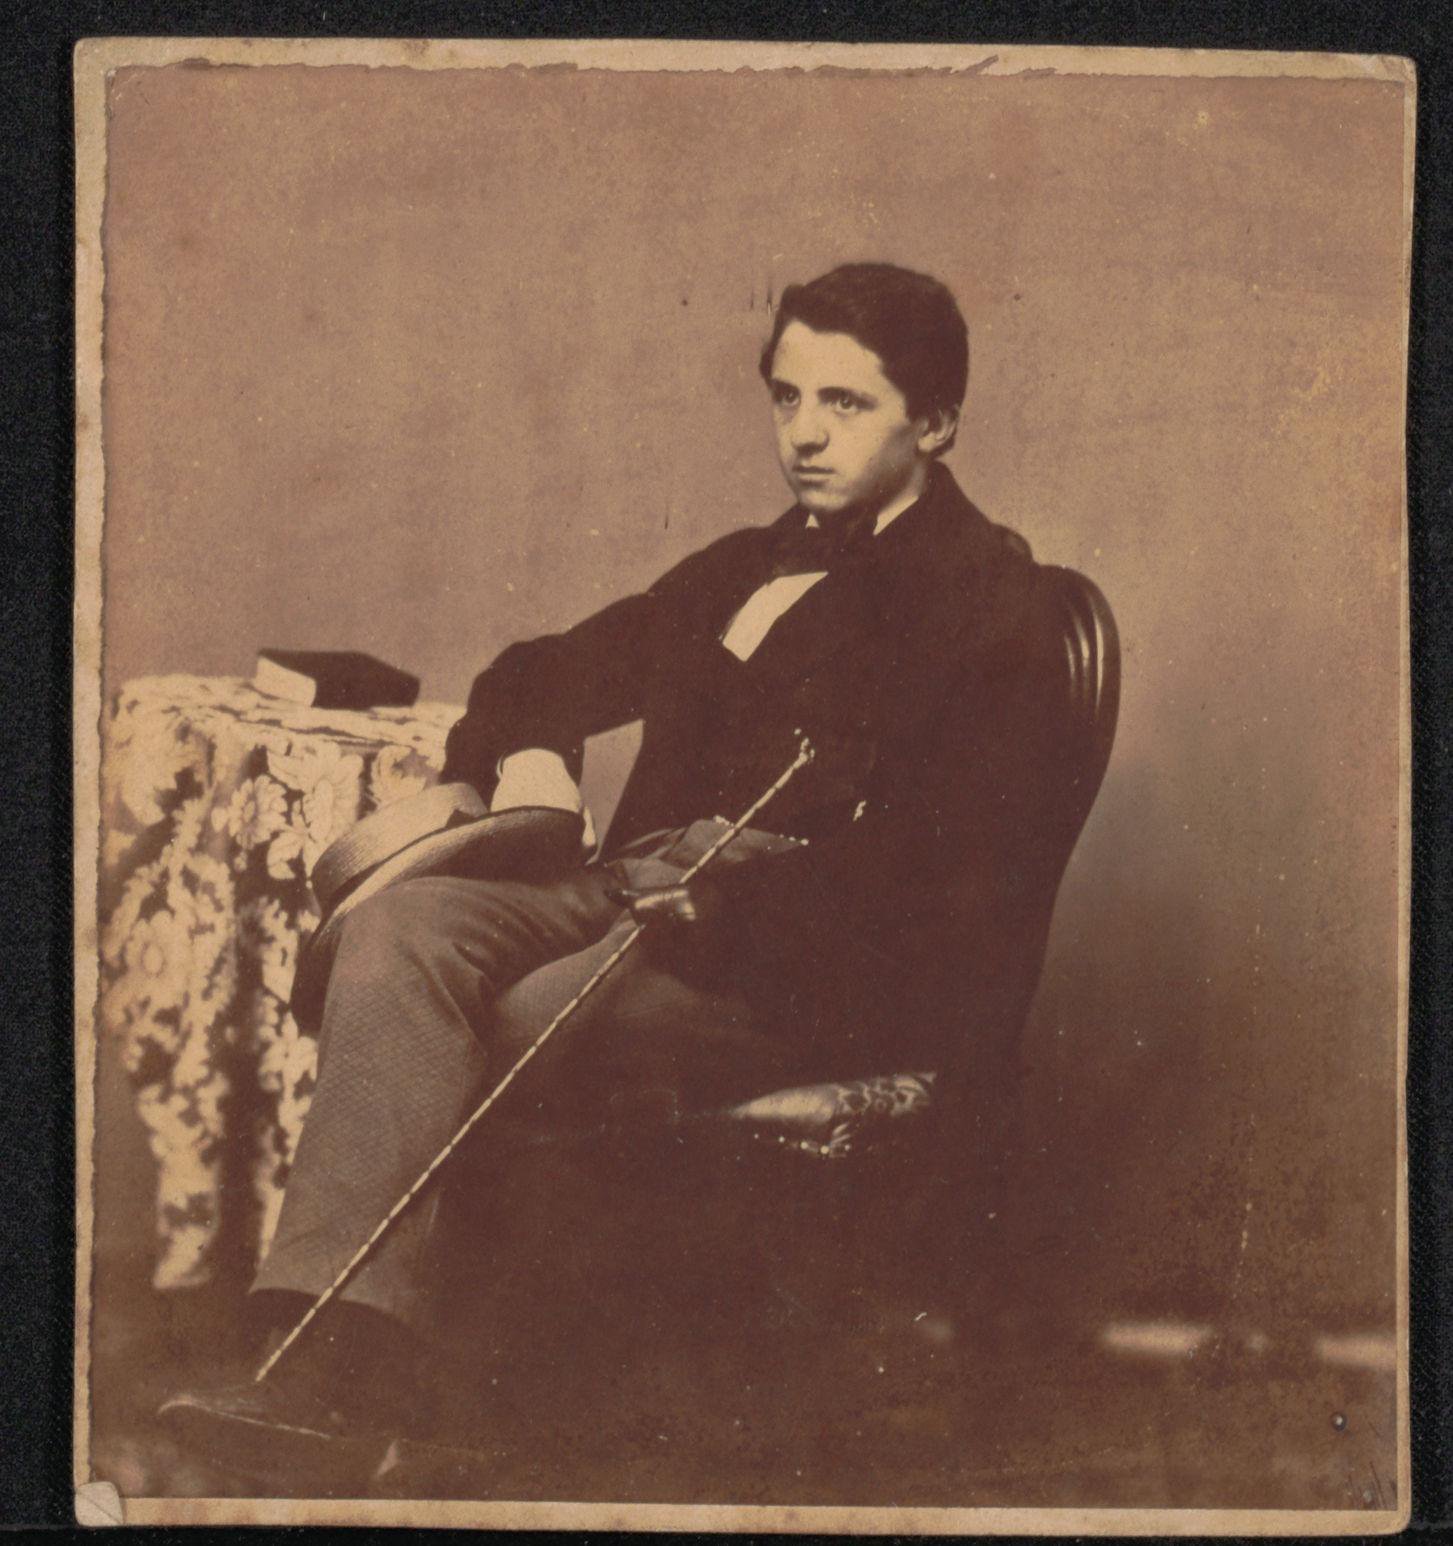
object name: photograph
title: Portret van Abraham Kuyper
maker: Anonymous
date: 1857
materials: cardboard, photographic support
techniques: albumen print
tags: the hague, abraham kuyper, walking-stick, staff, table, head-gear: hat, historical persons (portraits and scenes from the life)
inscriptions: collector's mark: ‘RPK’, inscription: ‘Dr. A. Kuyper/ aet auu XX/ a. 1857’